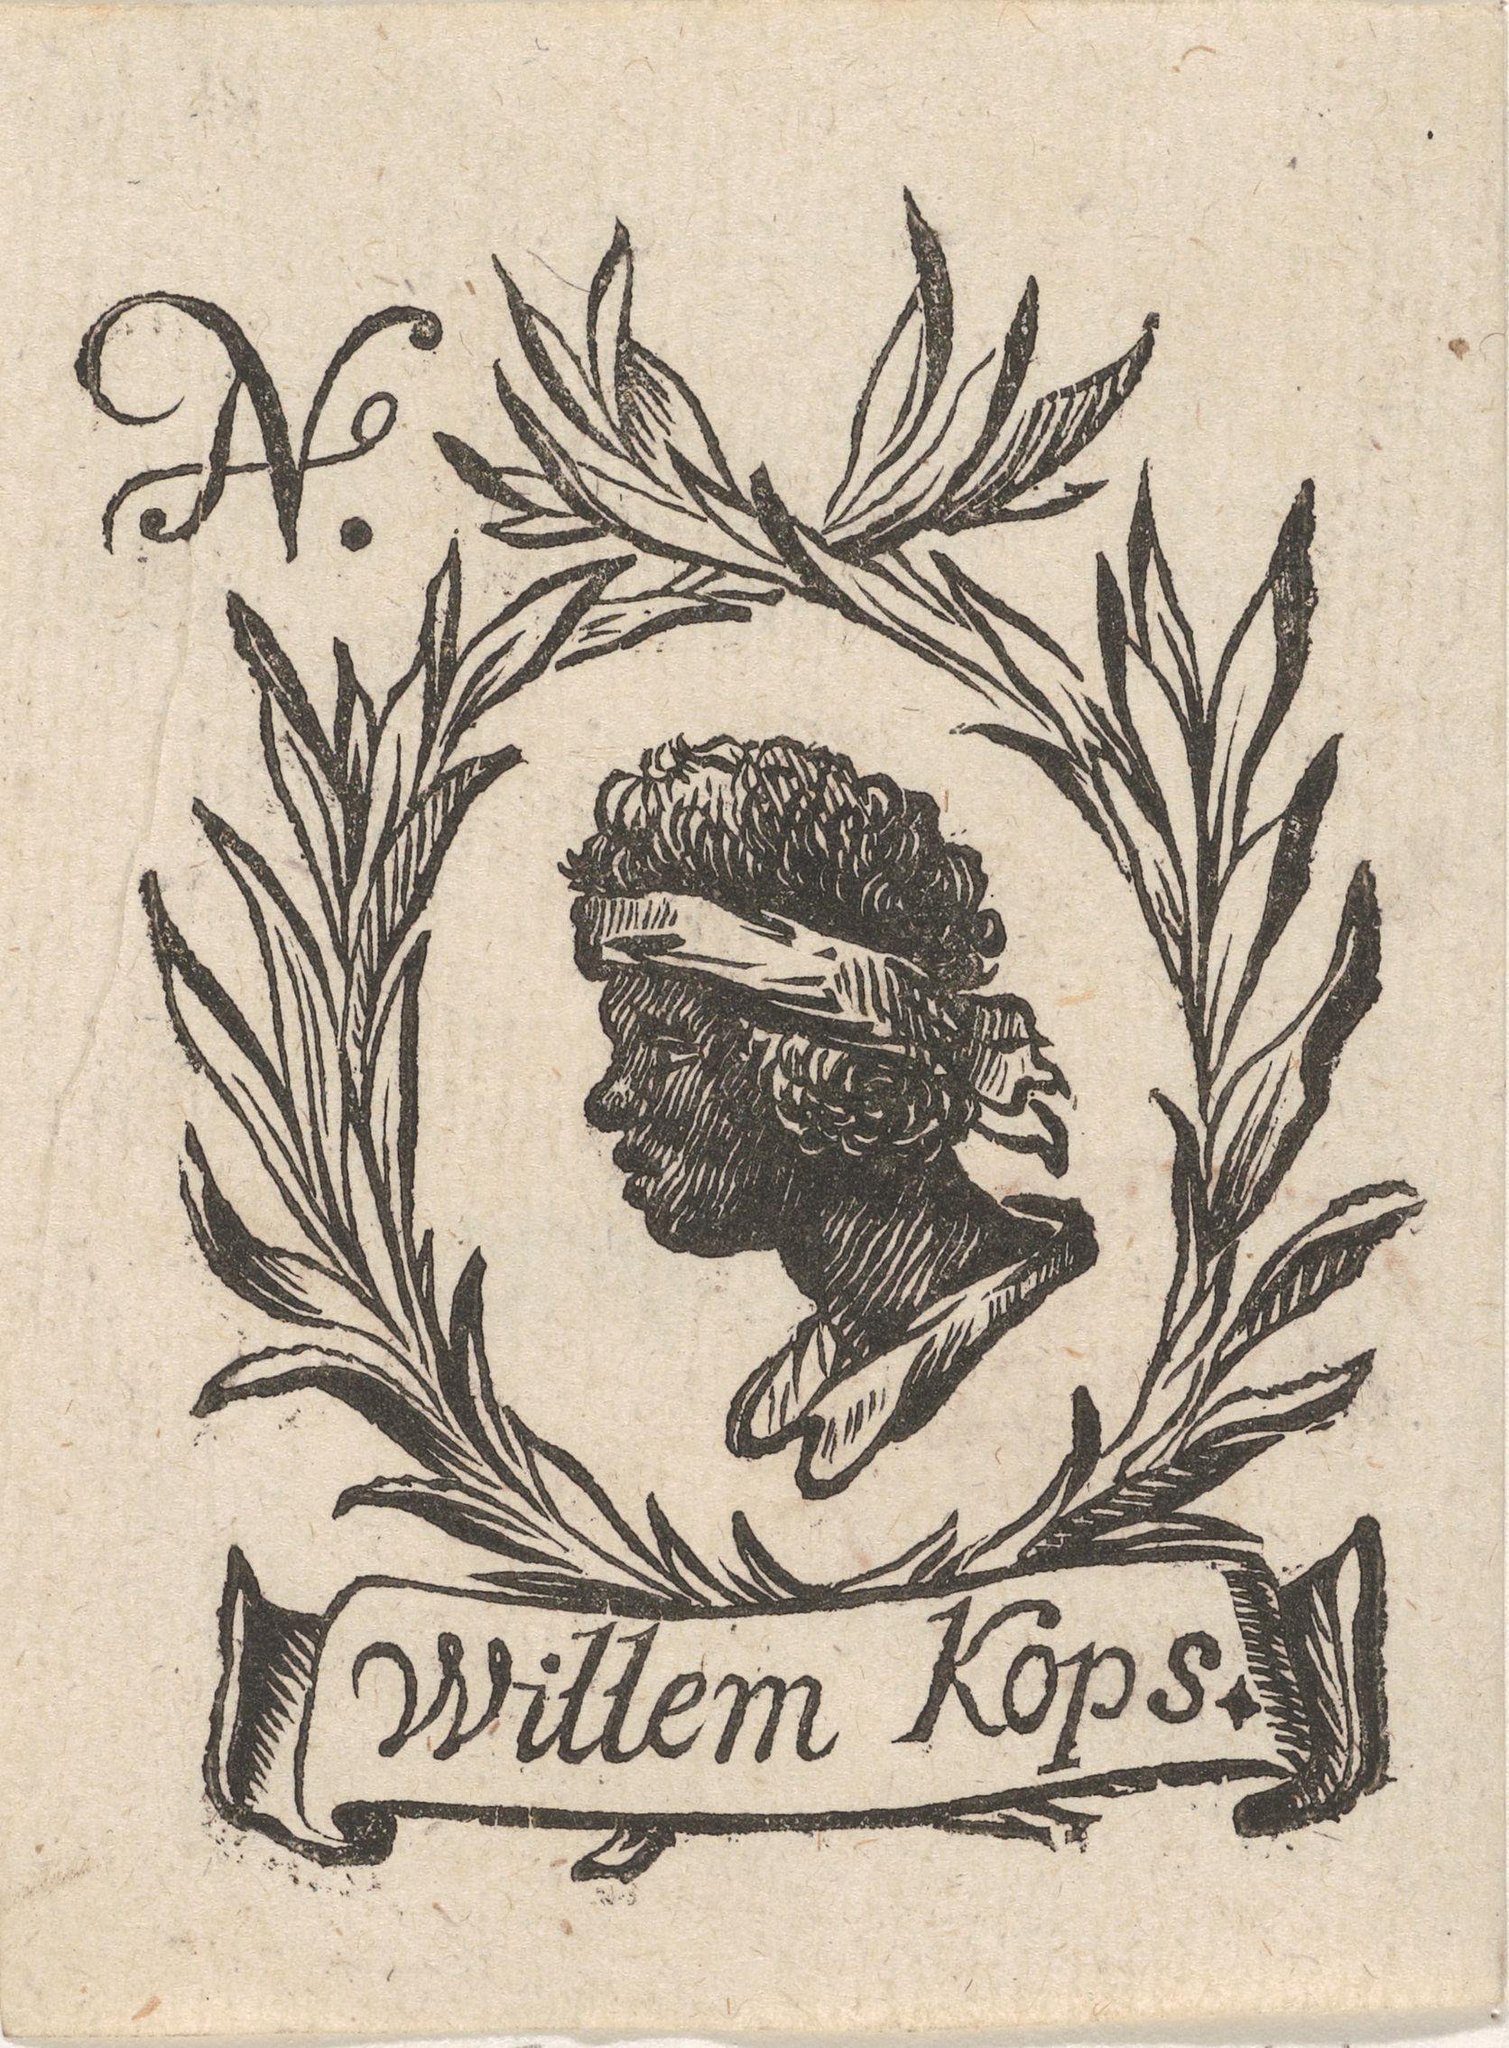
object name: handelsetiket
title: Handelsetiket van Willem Kops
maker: isaac vincentsz. van der vinne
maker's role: draughtsman, print maker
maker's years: 1665-1740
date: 1681-1740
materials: paper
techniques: woodcut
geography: haarlem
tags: vignette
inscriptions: collector's mark: Lugt 240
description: Met hoofd van een zwarte man in een lauwerkrans.